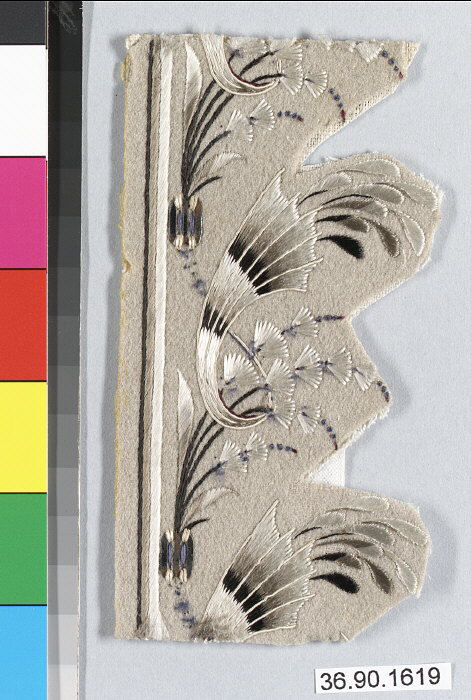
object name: sample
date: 1801-1833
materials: felt, silk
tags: flowers